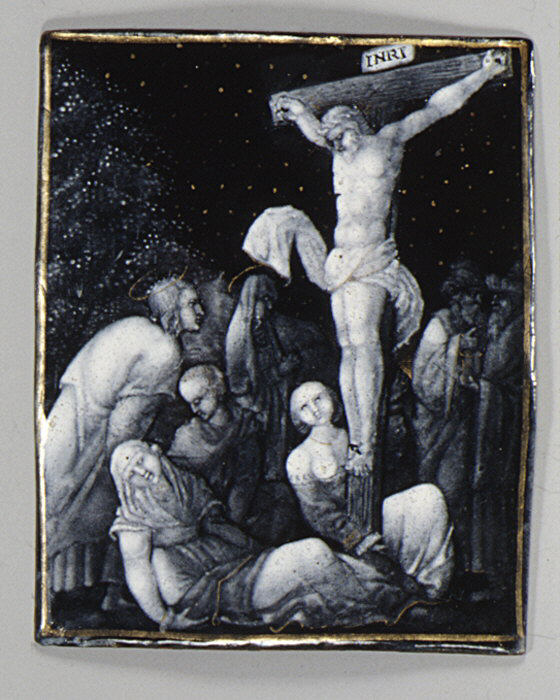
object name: plaque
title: The Crucifixion (one of seven)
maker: jean ii pénicaud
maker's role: enameler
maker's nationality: french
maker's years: 1524-1554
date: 1534-1566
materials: copper, enamel, gilt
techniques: painting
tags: christ,virgin mary,cross,crucifixion